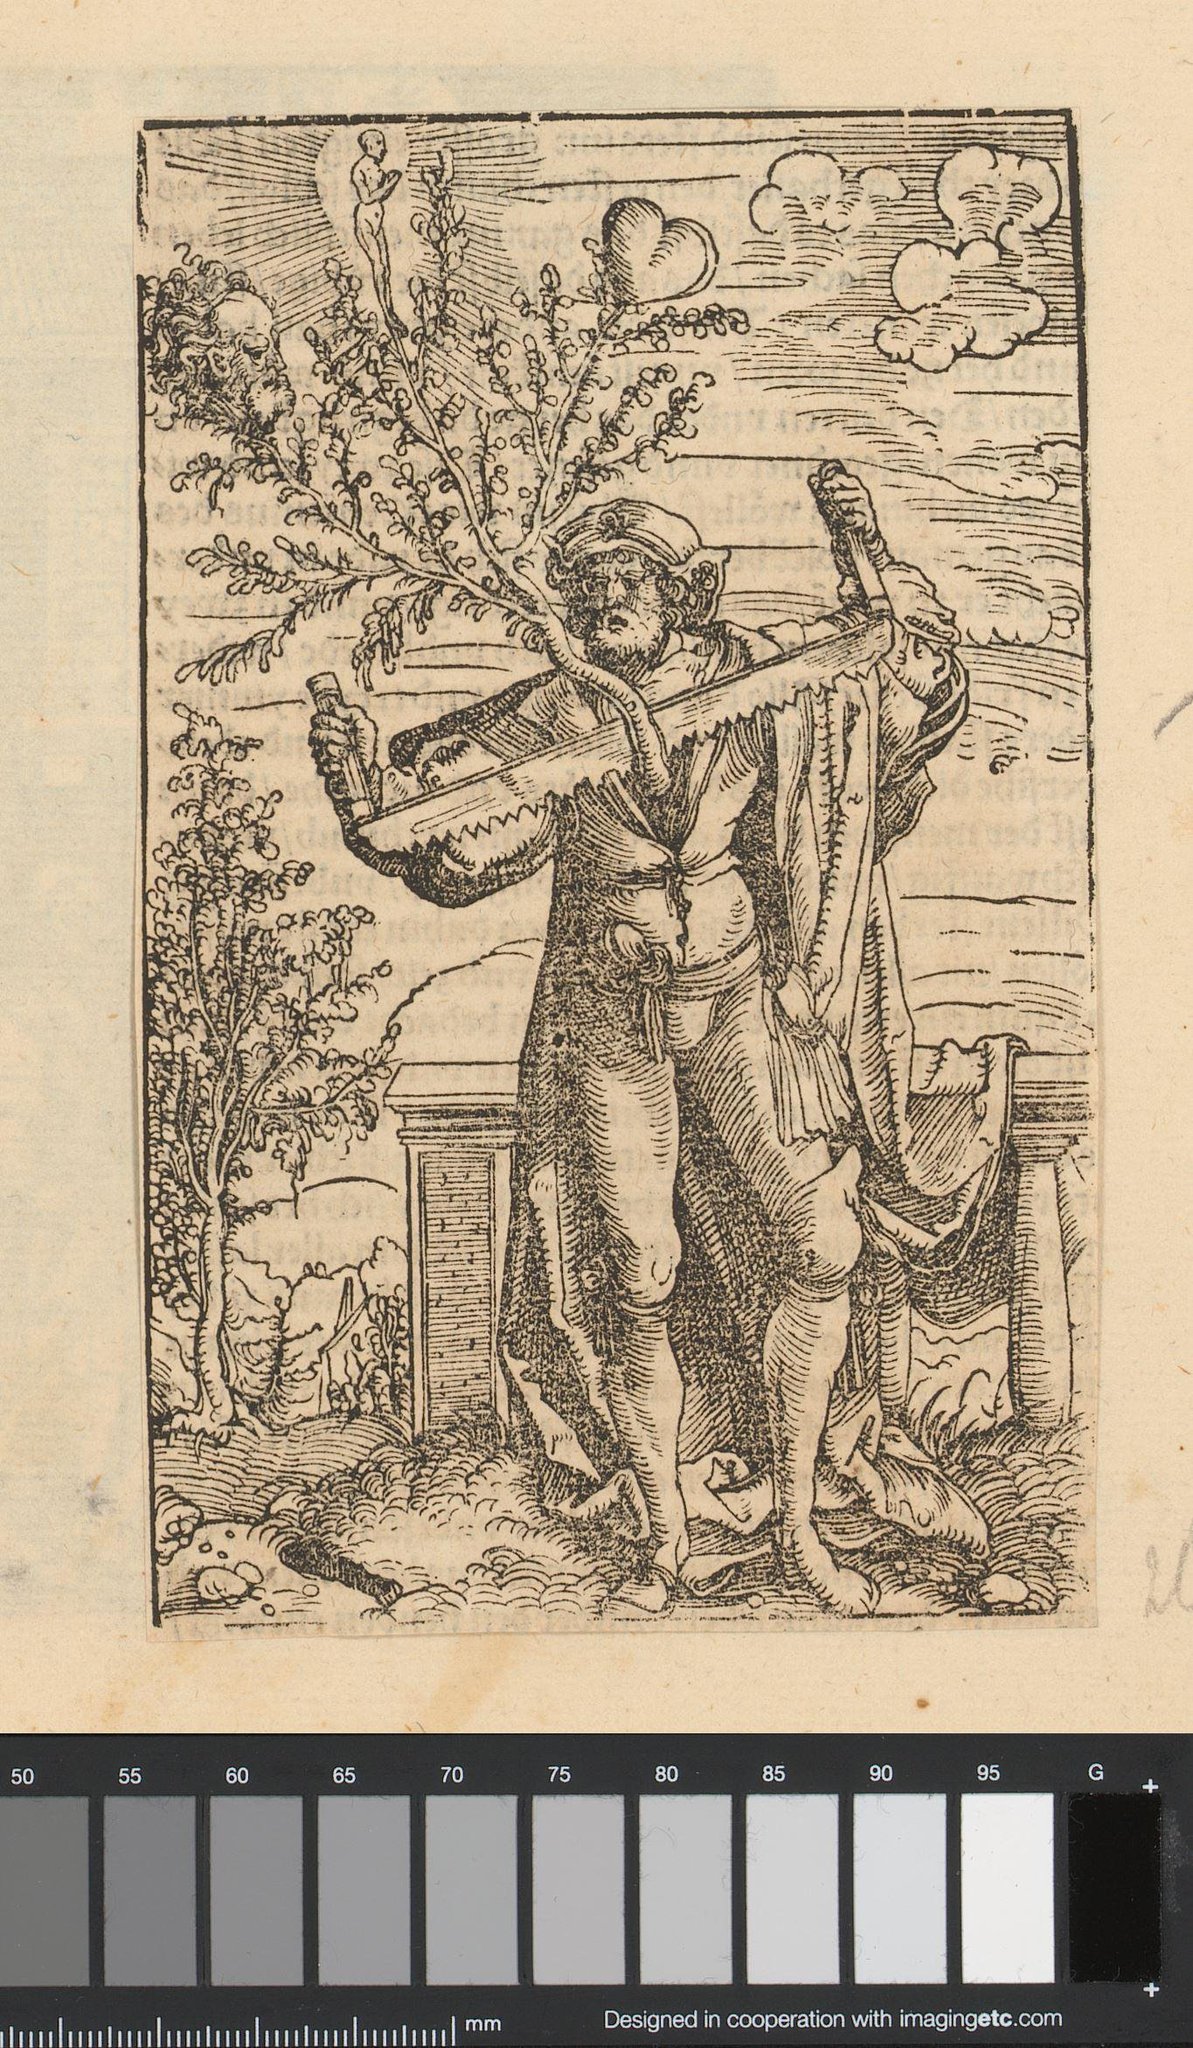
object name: book illustration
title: Man zaagt een boom af die uit zijn borst groeit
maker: Anonymous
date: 1514-1532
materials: paper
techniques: letterpress printing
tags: wise men versus fools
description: Deze prent is gebruikt in: Petrarca, Francesco. Von der Artzney bayder Glück, des guten und widerwertigen: unnd weß sich ain yeder inn Gelück und Unglück halten sol (...). Augsburg: Heinrich Steiner, 1532. Deze uitgave is ook bekend onder de titel 'Trostspiegel in Glück und Unglück'.